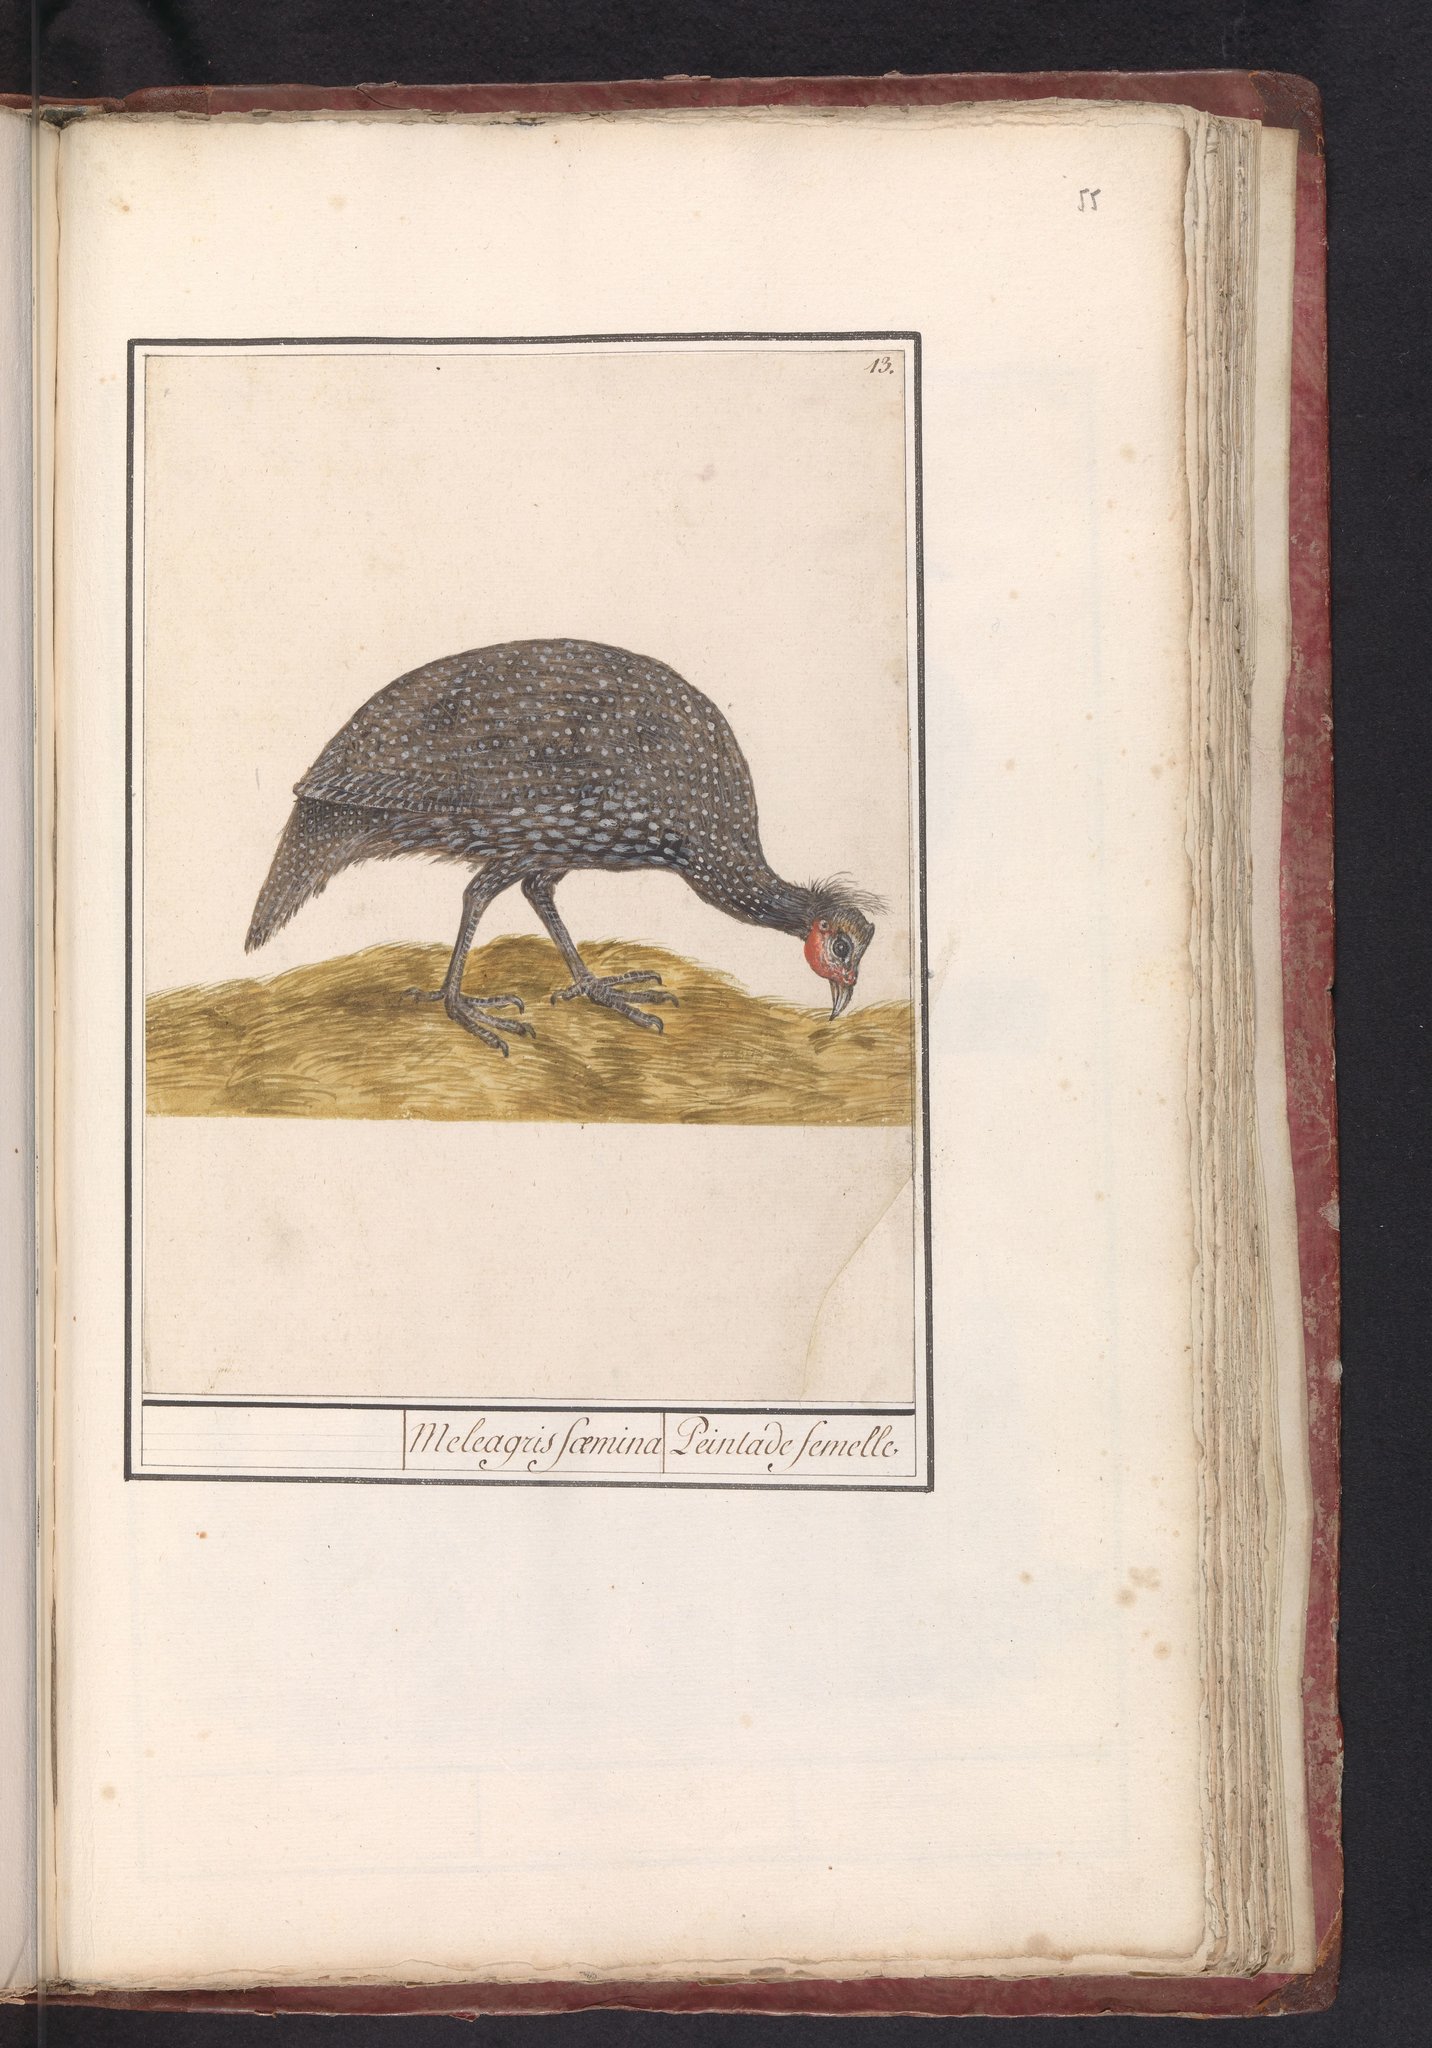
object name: drawing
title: Helmeted Guineafowl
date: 1596-1610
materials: paint, paper, watercolor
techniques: brush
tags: walker and runner birds: helmeted guineafowl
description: Helmparelhoen (hen). Genummerd rechtsboven: 13. Onderdeel van het eerste album met tekeningen van vogels. Derde van twaalf albums met tekeningen van dieren, vogels en planten bekend rond 1600, gemaakt in opdracht van keizer Rudolf II. Met toelichting in Nederlands, Latijn en Frans.